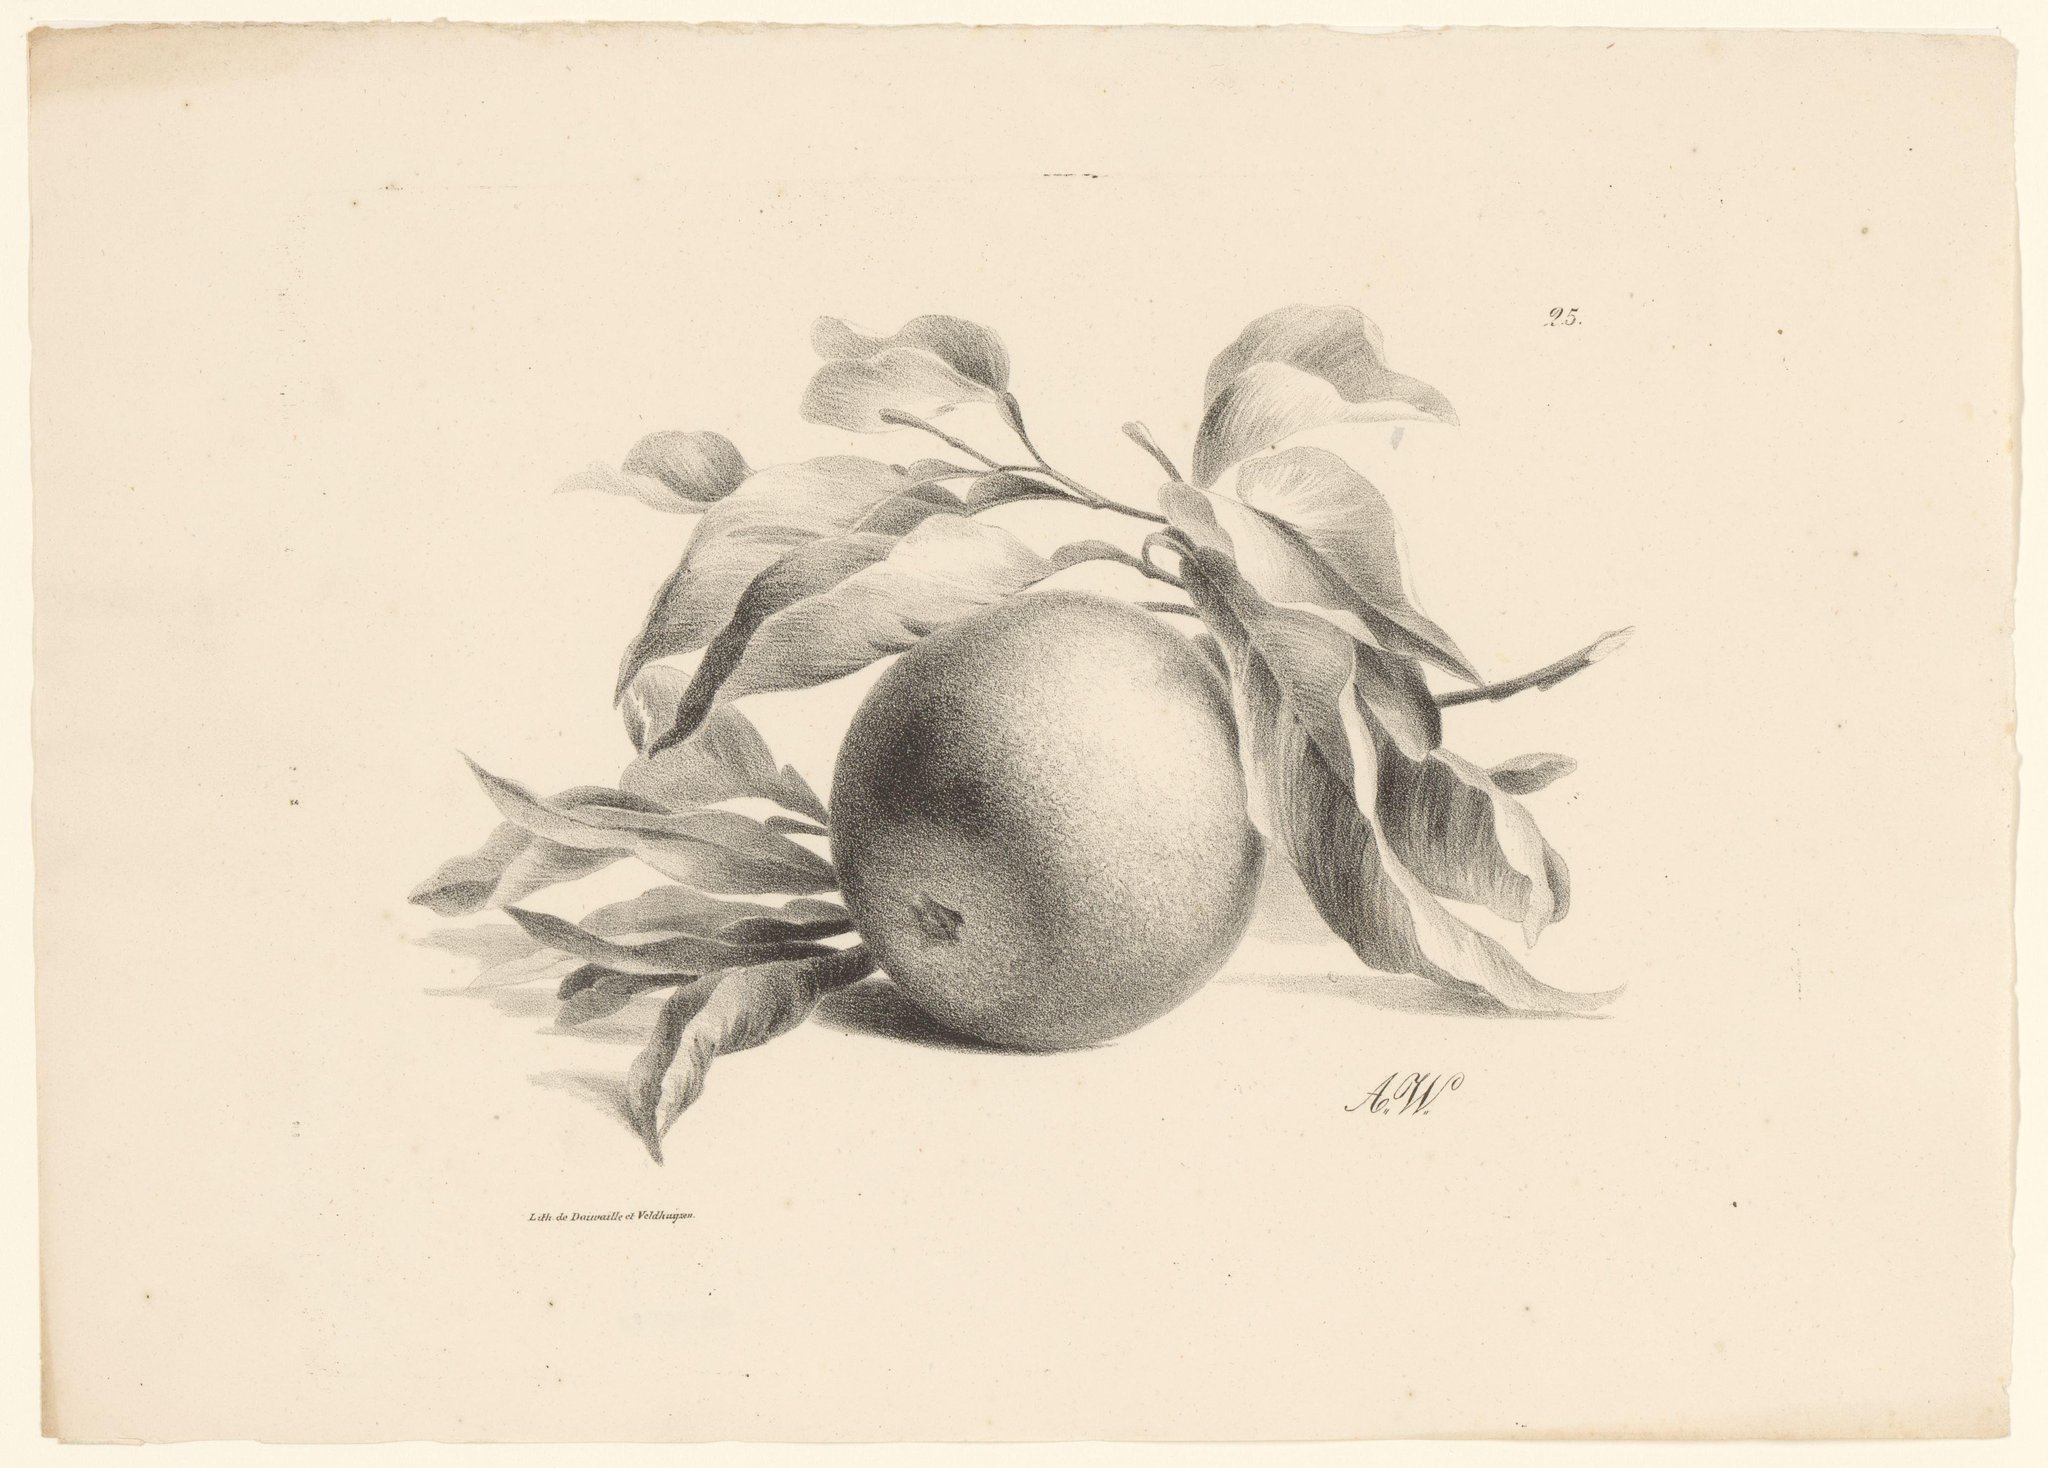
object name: print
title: Sinaasappel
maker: anton weiss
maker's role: draughtsman, print maker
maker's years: 1801-1851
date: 1831-1832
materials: paper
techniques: lithograph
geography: amsterdam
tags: fruits